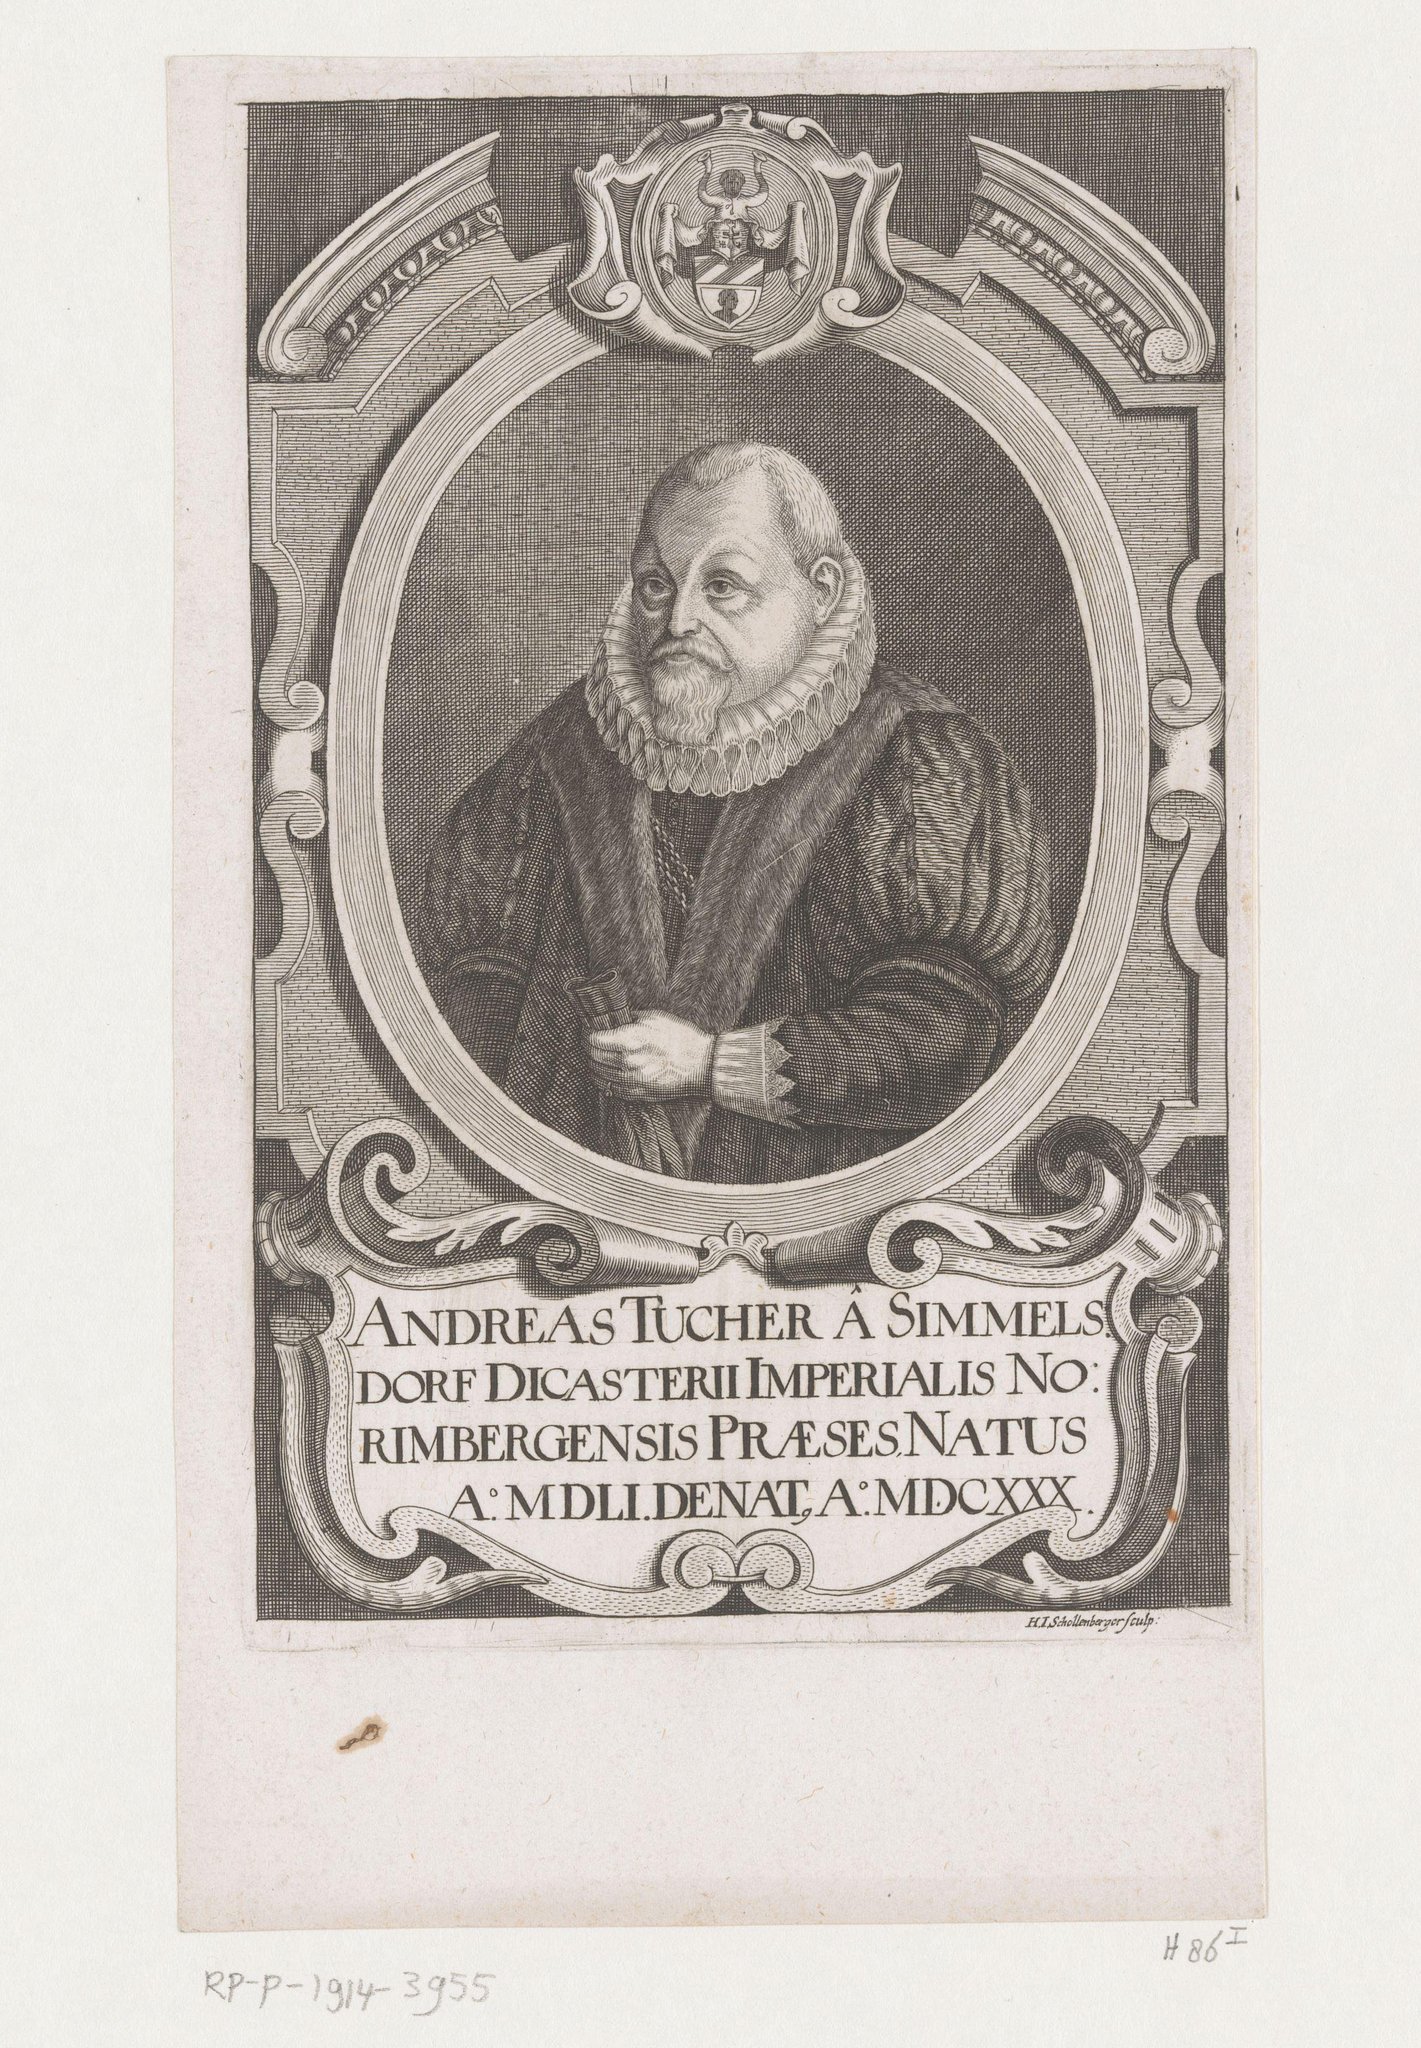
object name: print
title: Portret van Andreas Tucher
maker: johann jacob schollenberger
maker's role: print maker, publisher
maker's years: 1646-1689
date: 1656-1689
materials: paper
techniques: engraving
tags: official; civil servant; functionary (in general), historical persons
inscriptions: collector's mark: Lugt 2228